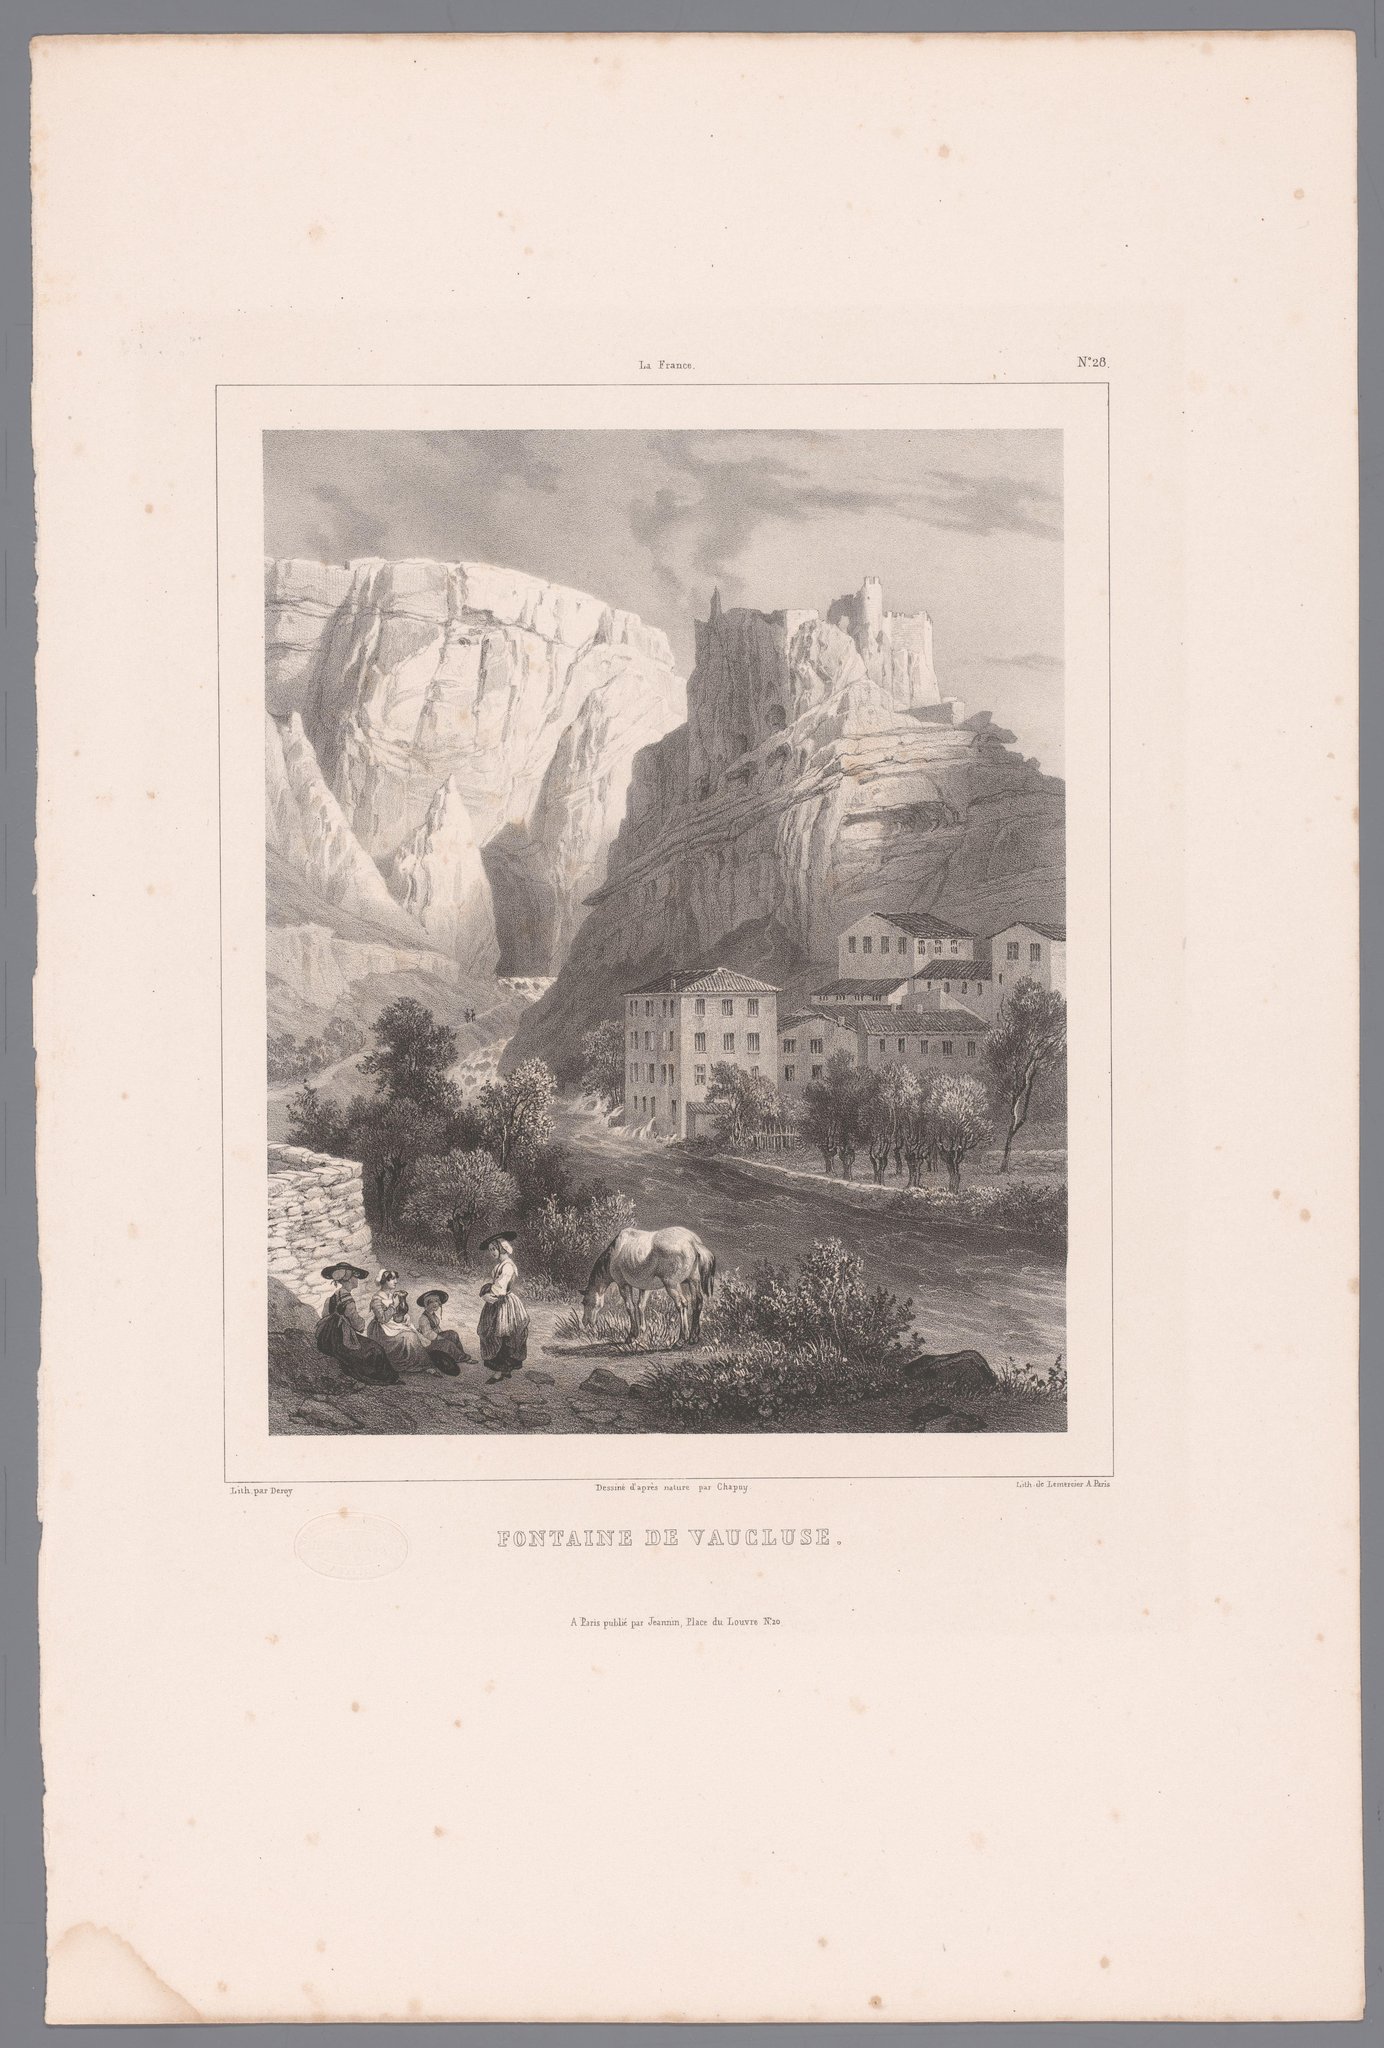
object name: print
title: Fontaine de Vaucluse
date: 1834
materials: paper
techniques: lithograph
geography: paris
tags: rocks (+ landscape with figures, staffage), prospect of village, silhouette of village (+ city(-scape) with figures, staffage), spring, source of river or stream (+ landscape with figures, staffage)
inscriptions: check stamp: Lugt 1397c, collector's mark: Lugt 2228a